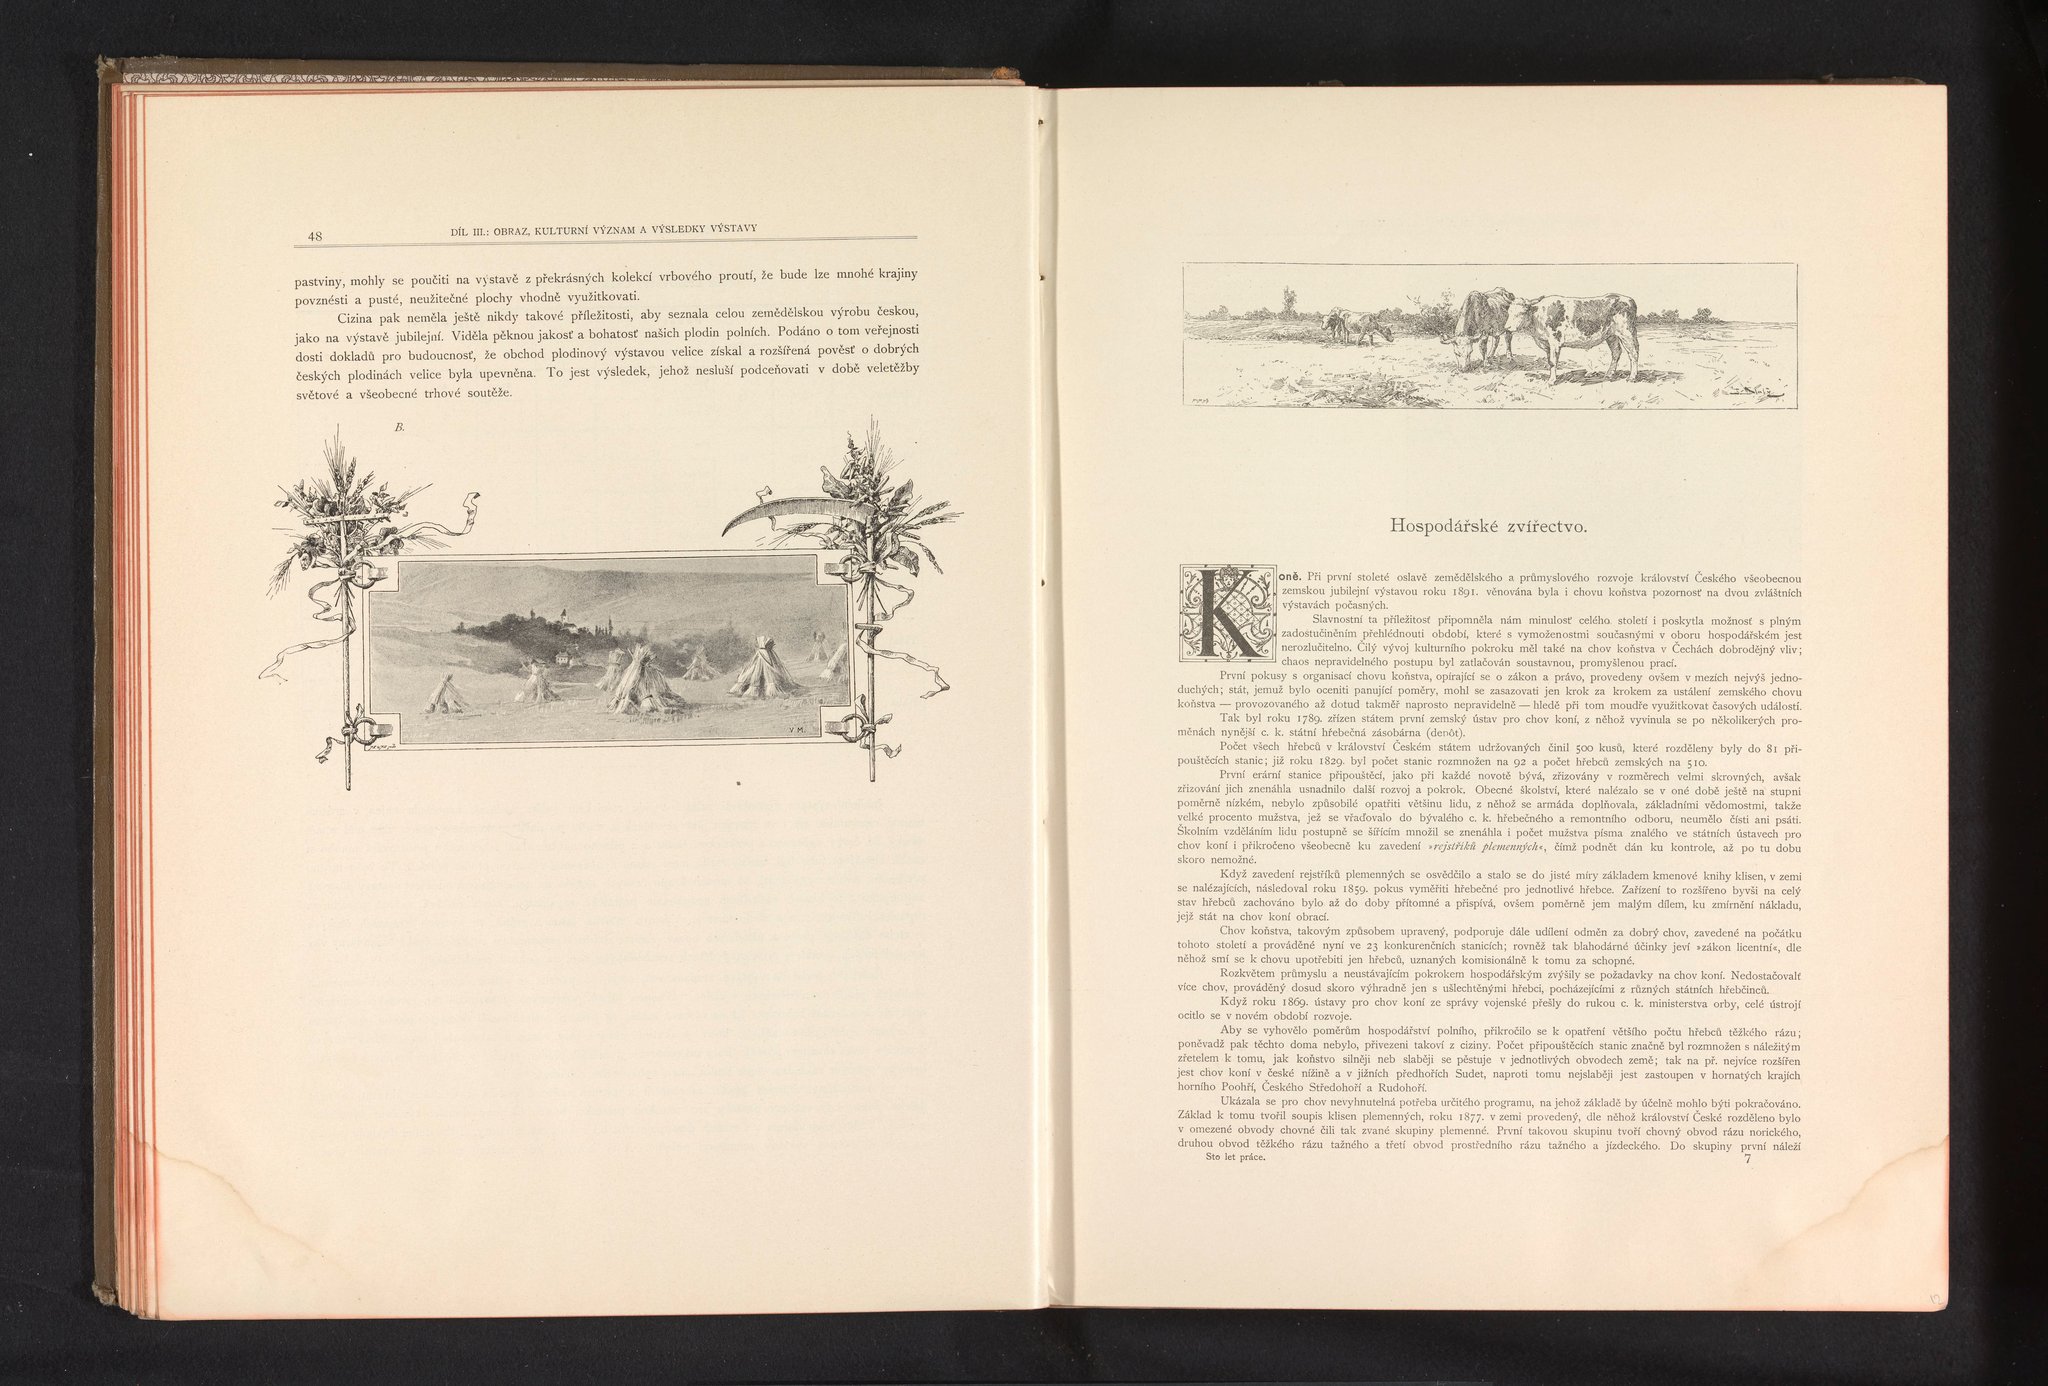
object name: reproduction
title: Fotoreproductie van een tekening, voorstellende hooibalen in een landschap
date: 1891-1895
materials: paper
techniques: autotype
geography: prague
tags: hay-stack